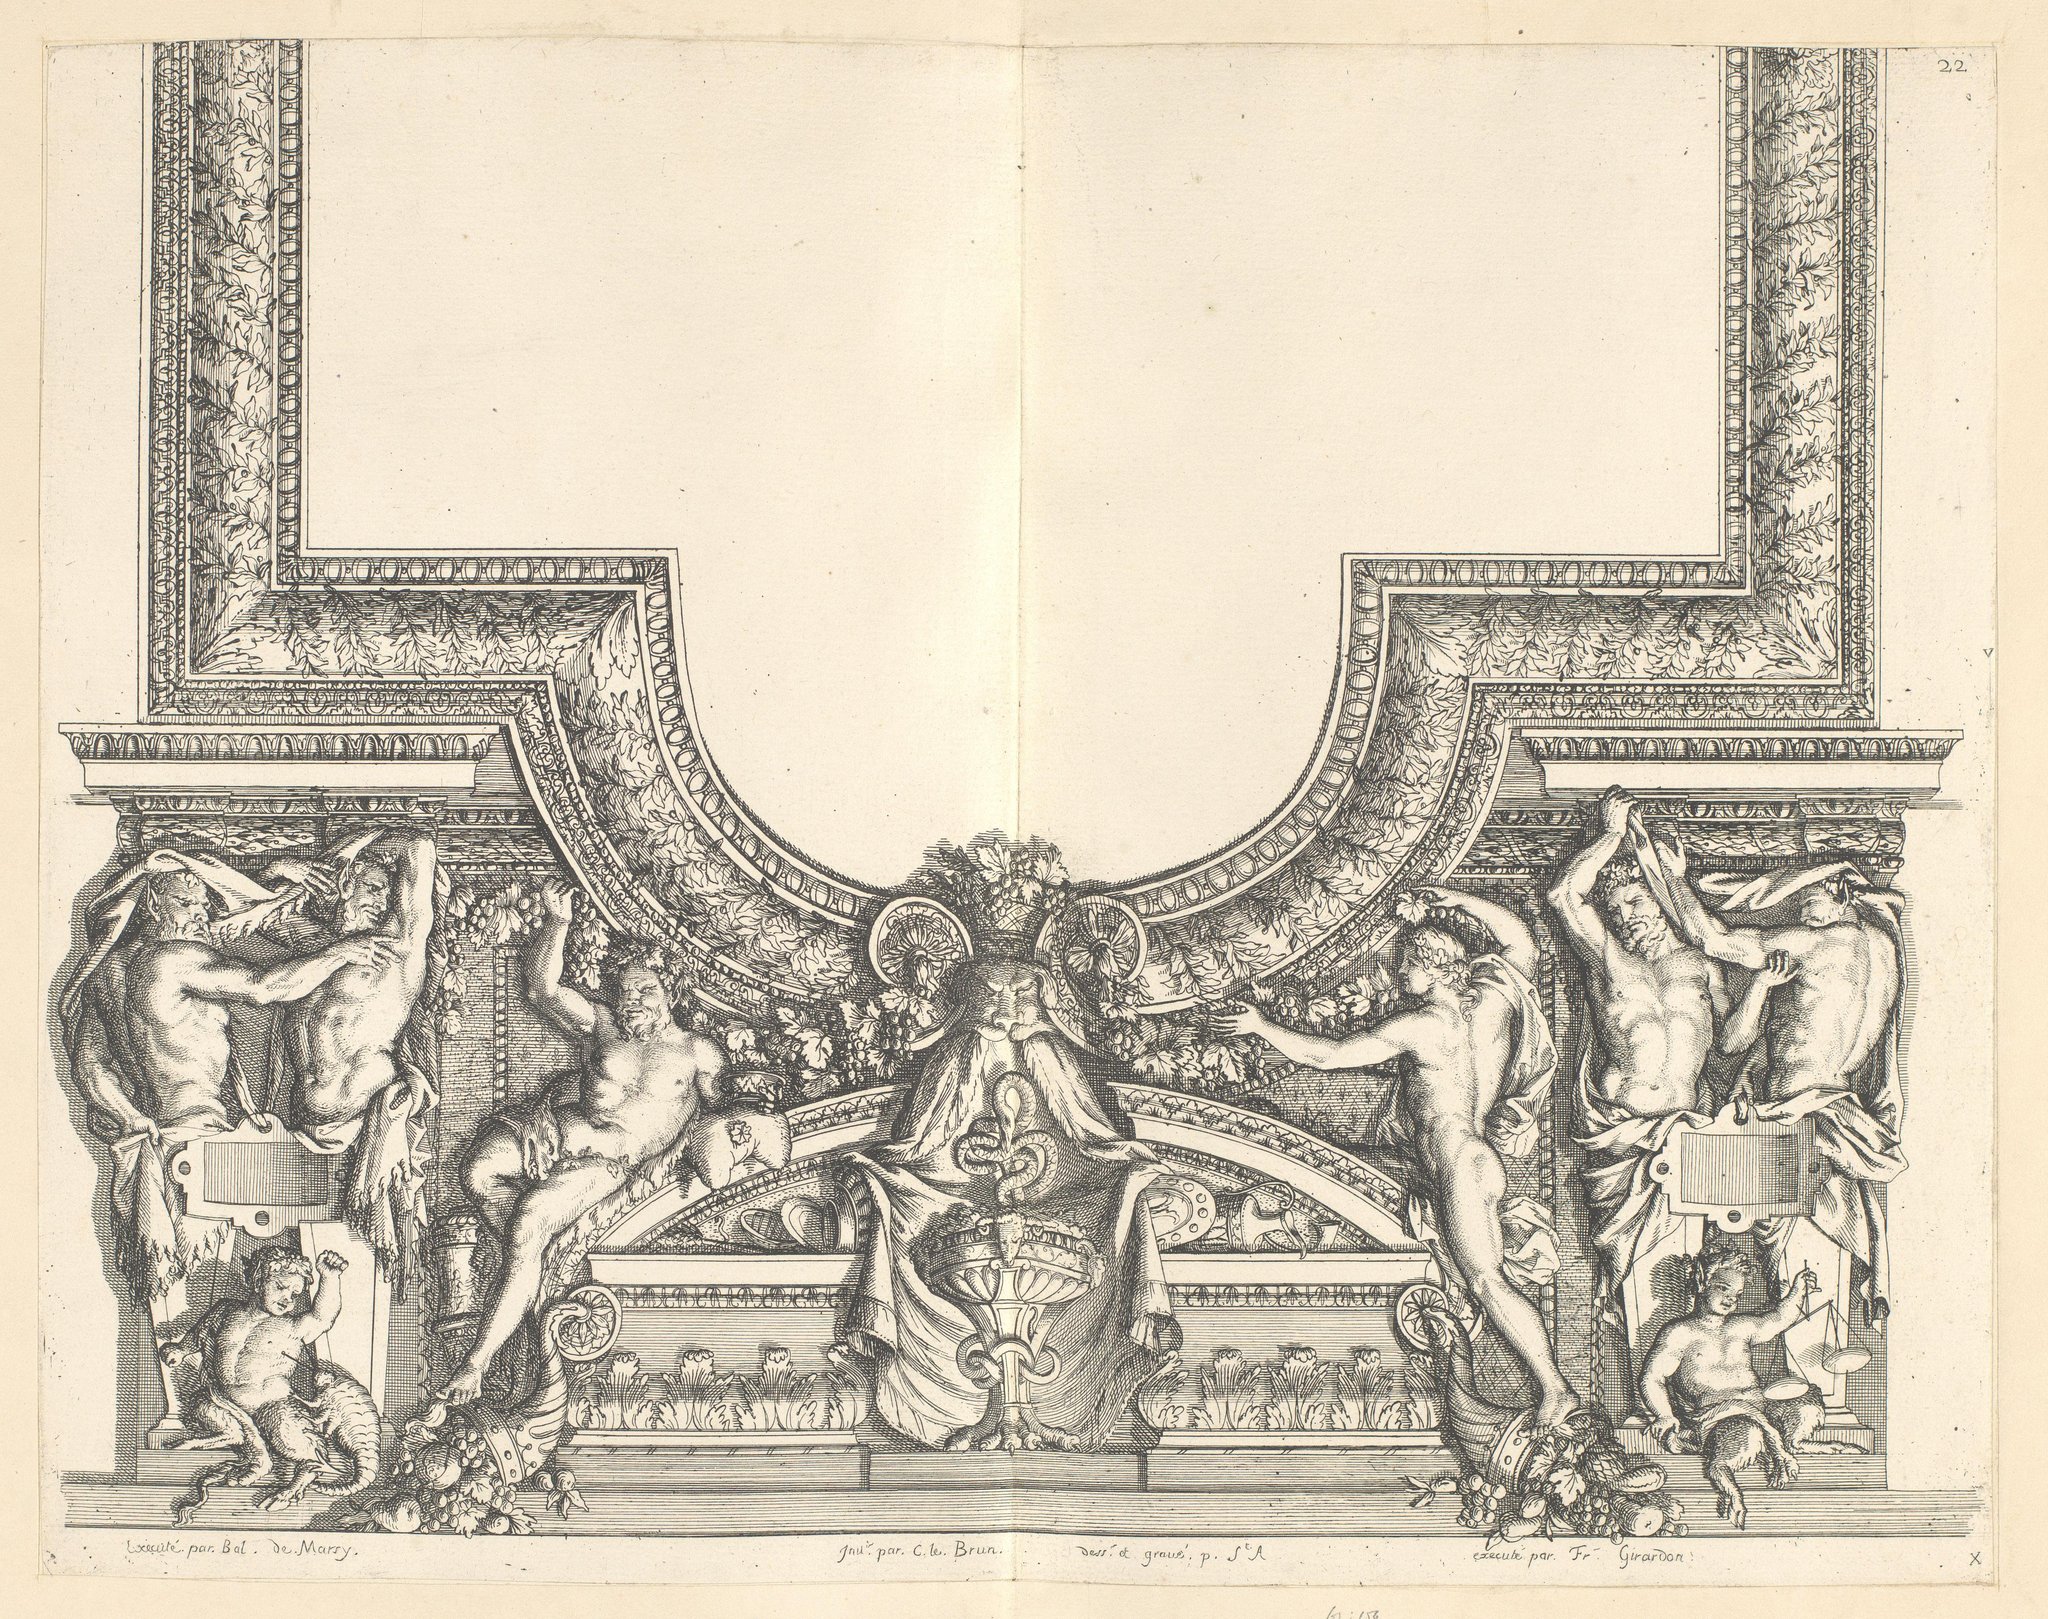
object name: album leaf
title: La Petite Gallerie du Louvre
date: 1695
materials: paper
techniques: etching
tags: ornaments ~ art, (story of) bacchus (dionysus), liber, maenad(s), female bacchant(es), satyr(s) (in general), (decorated) ceiling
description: Met onder andere Bacchus en een maenade, satyrs en cornucopia. Deze prent maakt deel uit van een album.